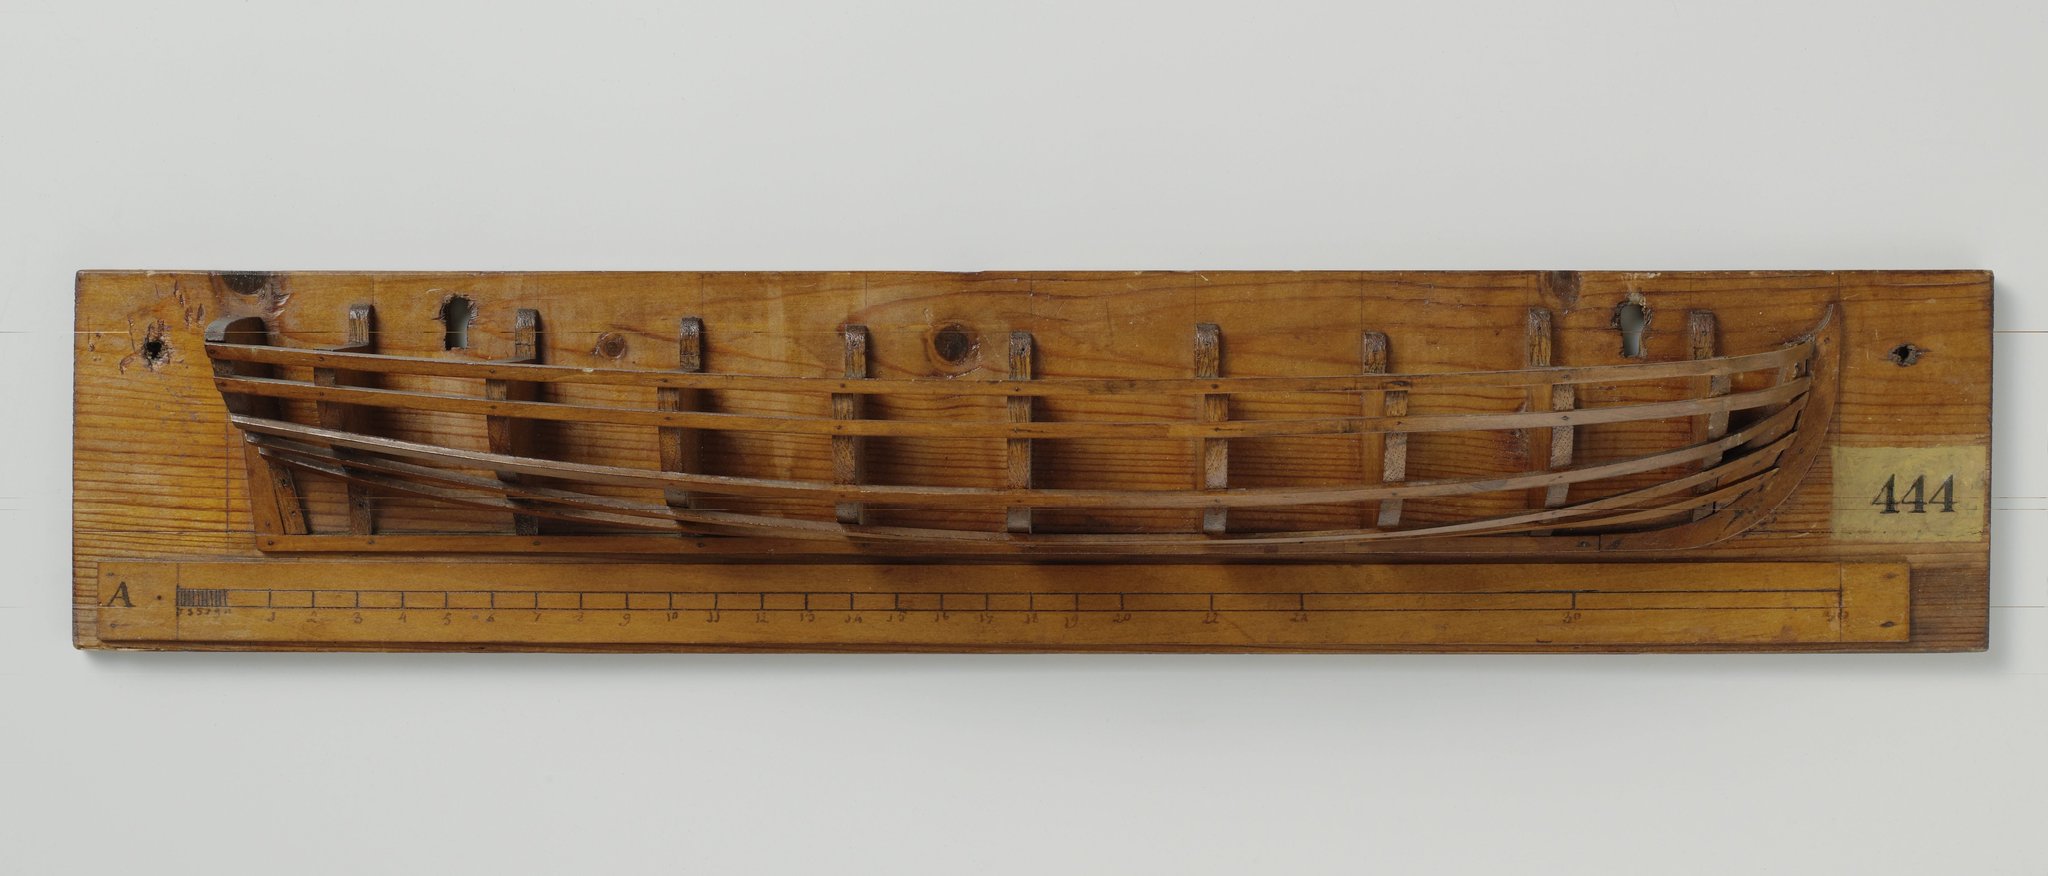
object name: half model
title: Half Model of a Launch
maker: Anonymous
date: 1780-1820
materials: wood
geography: netherlands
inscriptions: label, bottom right: ‘444’ former inventory label, inscription, on the scale: ‘A’, label, bottom centre: wooden scale in Amsterdam feet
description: Mallenmodel (stuurboord) van een sloep. Platte spiegel. De zeeg loopt op naar beide uiteinden. Gepiekt rondspant. Schaal ca. 1:20 (schaal op model). Volgens de schaal is deze jol 36 Amsterdamse voeten lang. Dit model is identiek aan NG-MC-442.